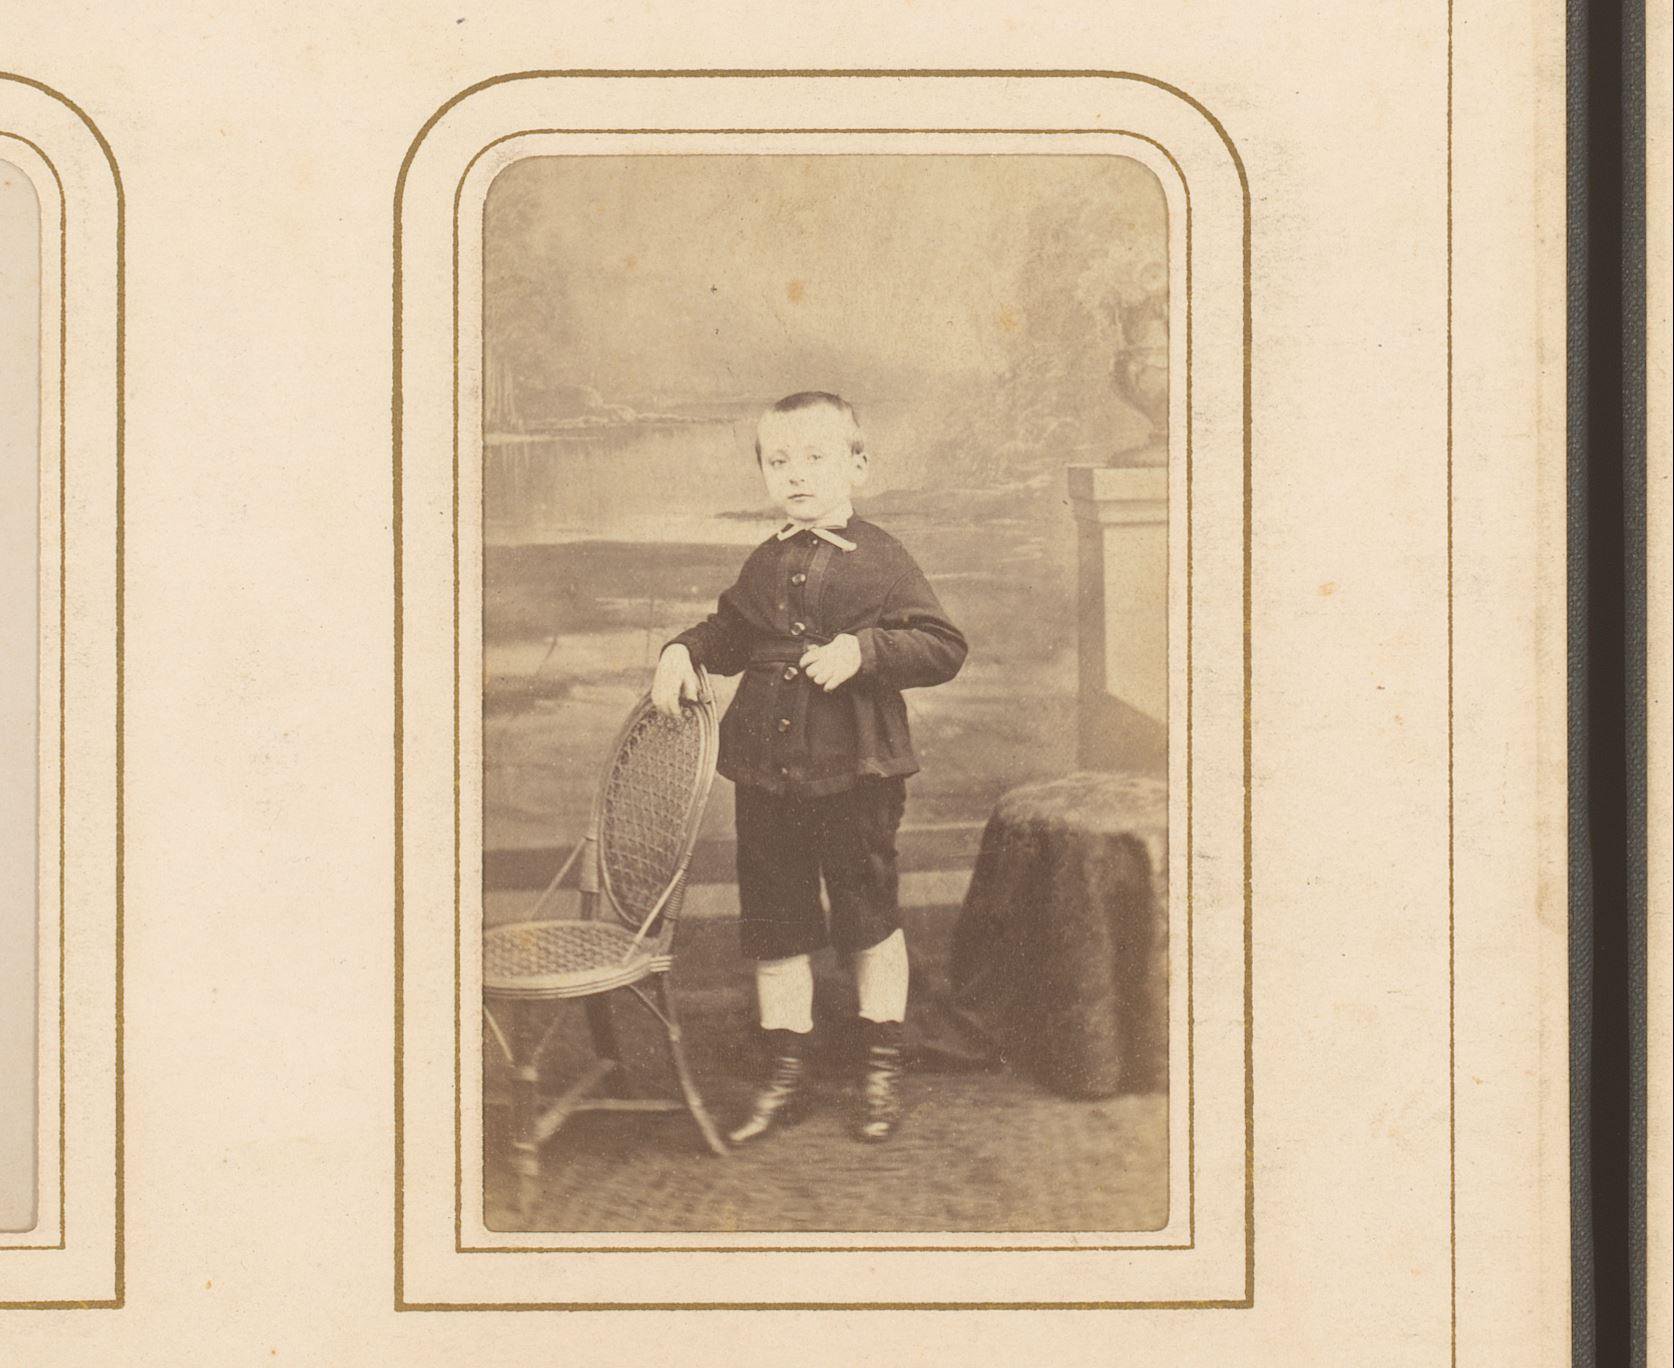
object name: carte de visite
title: Portret van een staande jongen bij een stoel, aangeduid als Louis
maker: prosper bevierre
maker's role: fotograaf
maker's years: 1822-1893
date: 1871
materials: cardboard, photographic support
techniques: albumen print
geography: charleroi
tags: boy (child between toddler and youth), historical persons, chair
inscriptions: annotation: ‘Le petit Louis vous/ souhaite une bonne/ année./ 1er Janvier 1871.’, inscription: ‘Bevierre/ Charleroi’